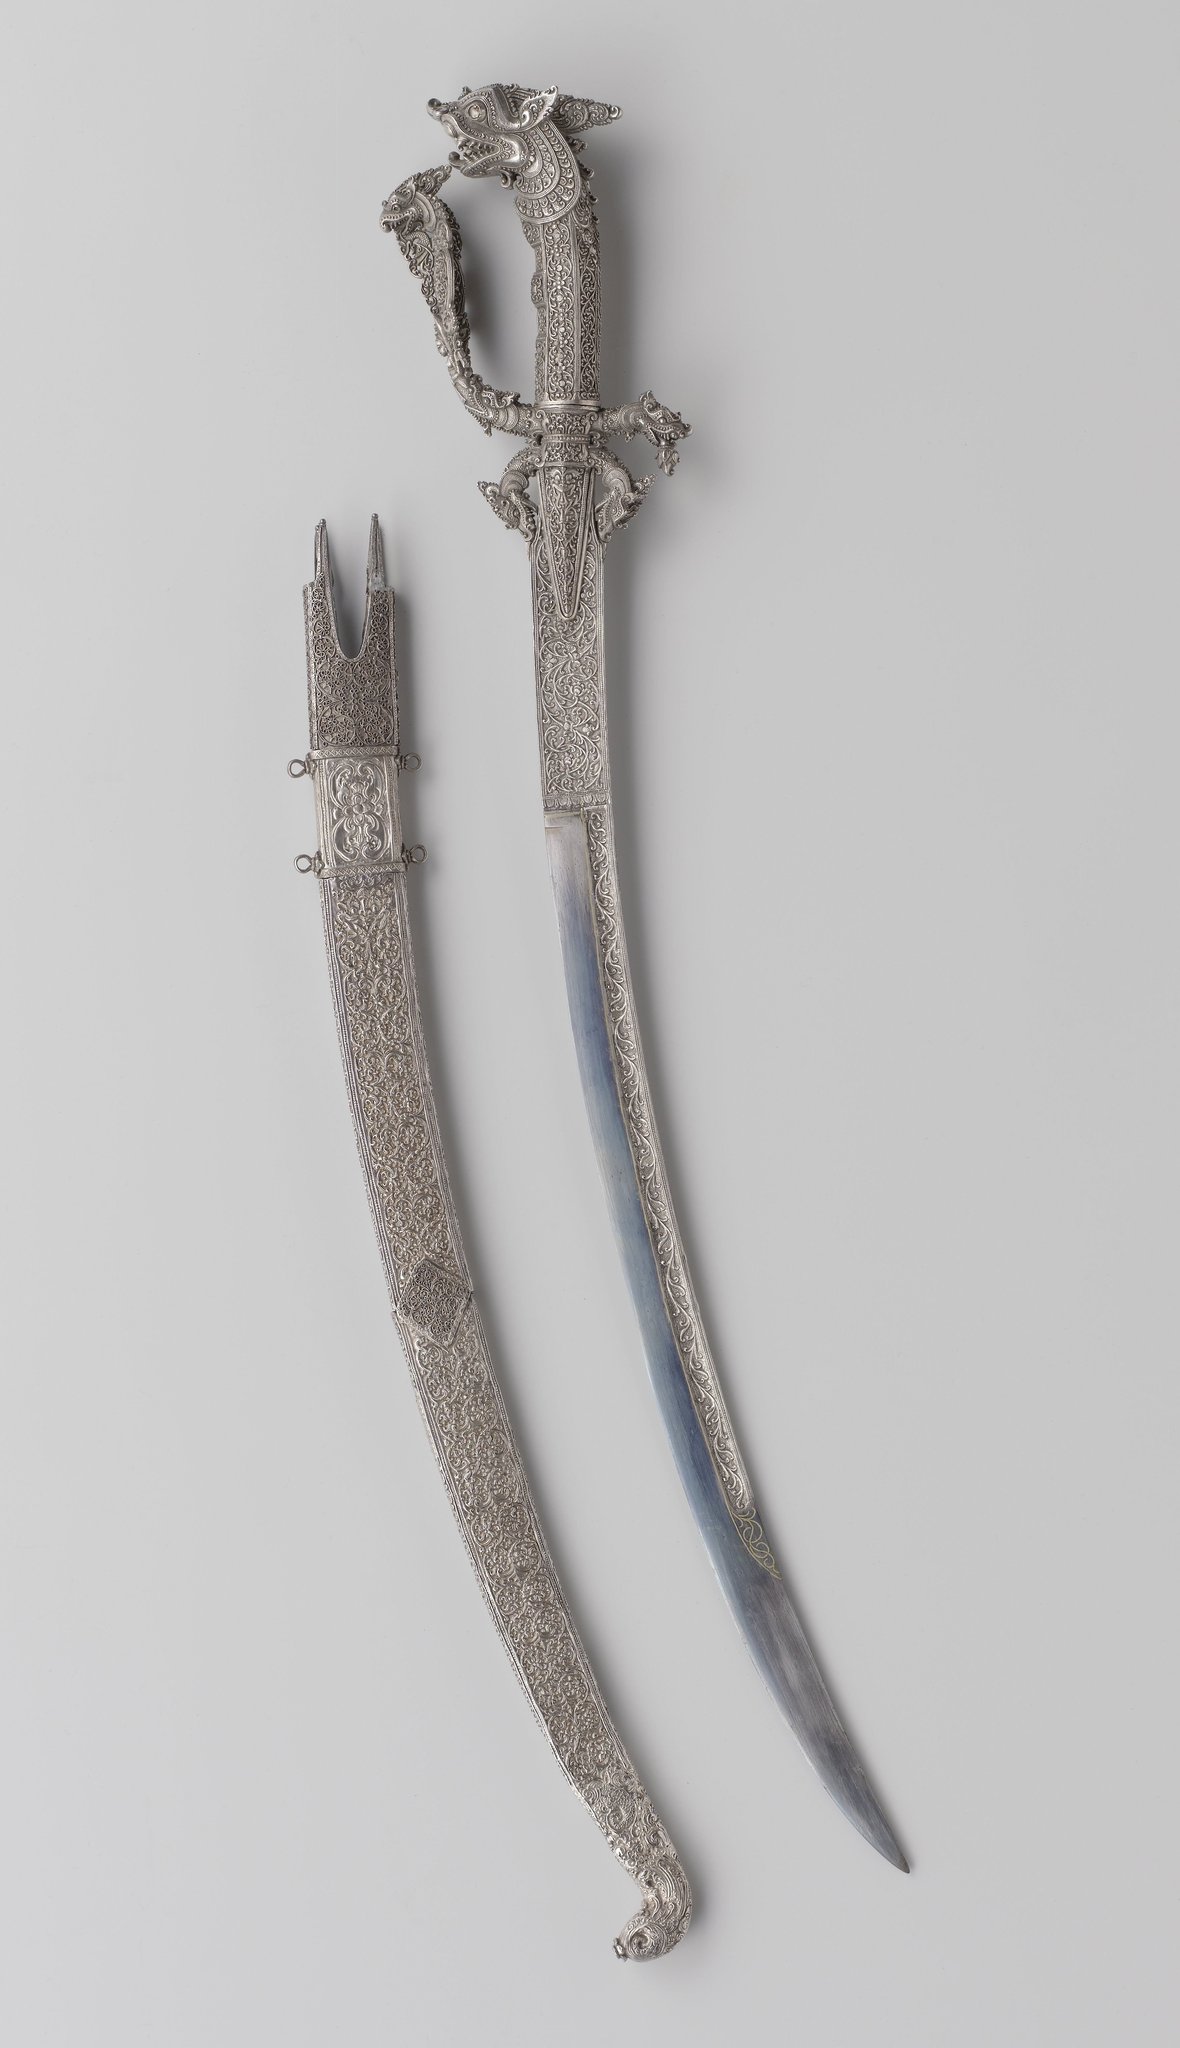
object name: saber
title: Twee sabels (kastanes) en een mes (piha-kaetta)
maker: Anonymous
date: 1765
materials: crystal, diamond, gold, iron, gemstone, silver, wood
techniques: casting, forging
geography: sri lanka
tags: dragon, ornament derived from plant forms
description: This silver sabre (kastane) was part of a group of six Sinhalese weapons from the Rijksmuseum’s collection that were returned to Sri Lanka by the Dutch State in 2023. After conducting joint provenance research, it was concluded that these weapons were captured by Dutch troops during the siege of the city of Kandy in Sri Lanka in 1765. Hence, there was involuntary loss of possession, prompting the restitution of these objects. The sabre and the other weapons are now on display at the Colombo National Museum.